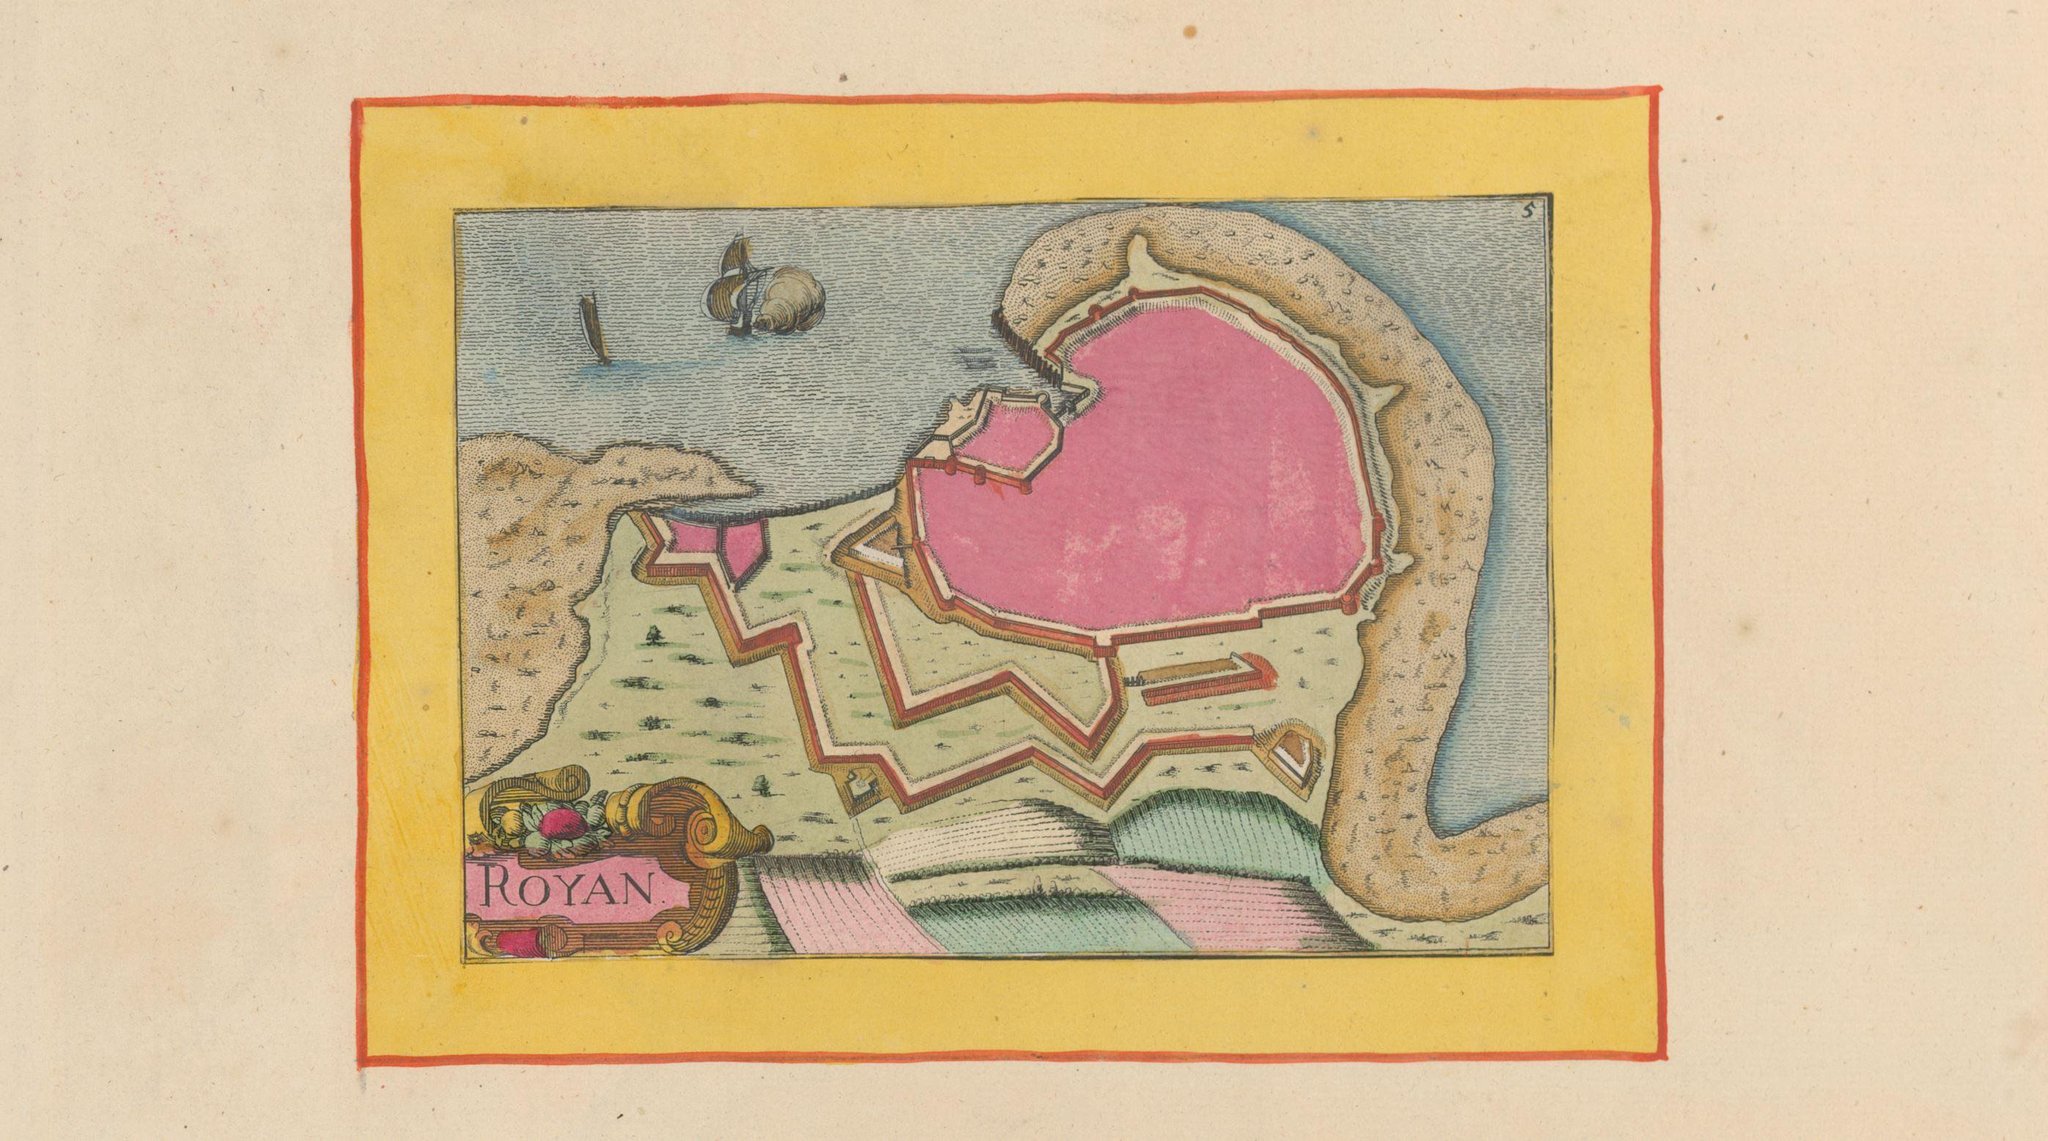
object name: area plan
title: Plattegrond van Royan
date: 1638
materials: paper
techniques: engraving, etching, hand coloring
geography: paris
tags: maps of cities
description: Prent uit: Tassin, Christophe. Les plans et profils de toutes les principales villes et lieux considérables de France (...). Parijs: Michel van Lochom, 1638, prent 5 uit het deel 'Guyenne'.